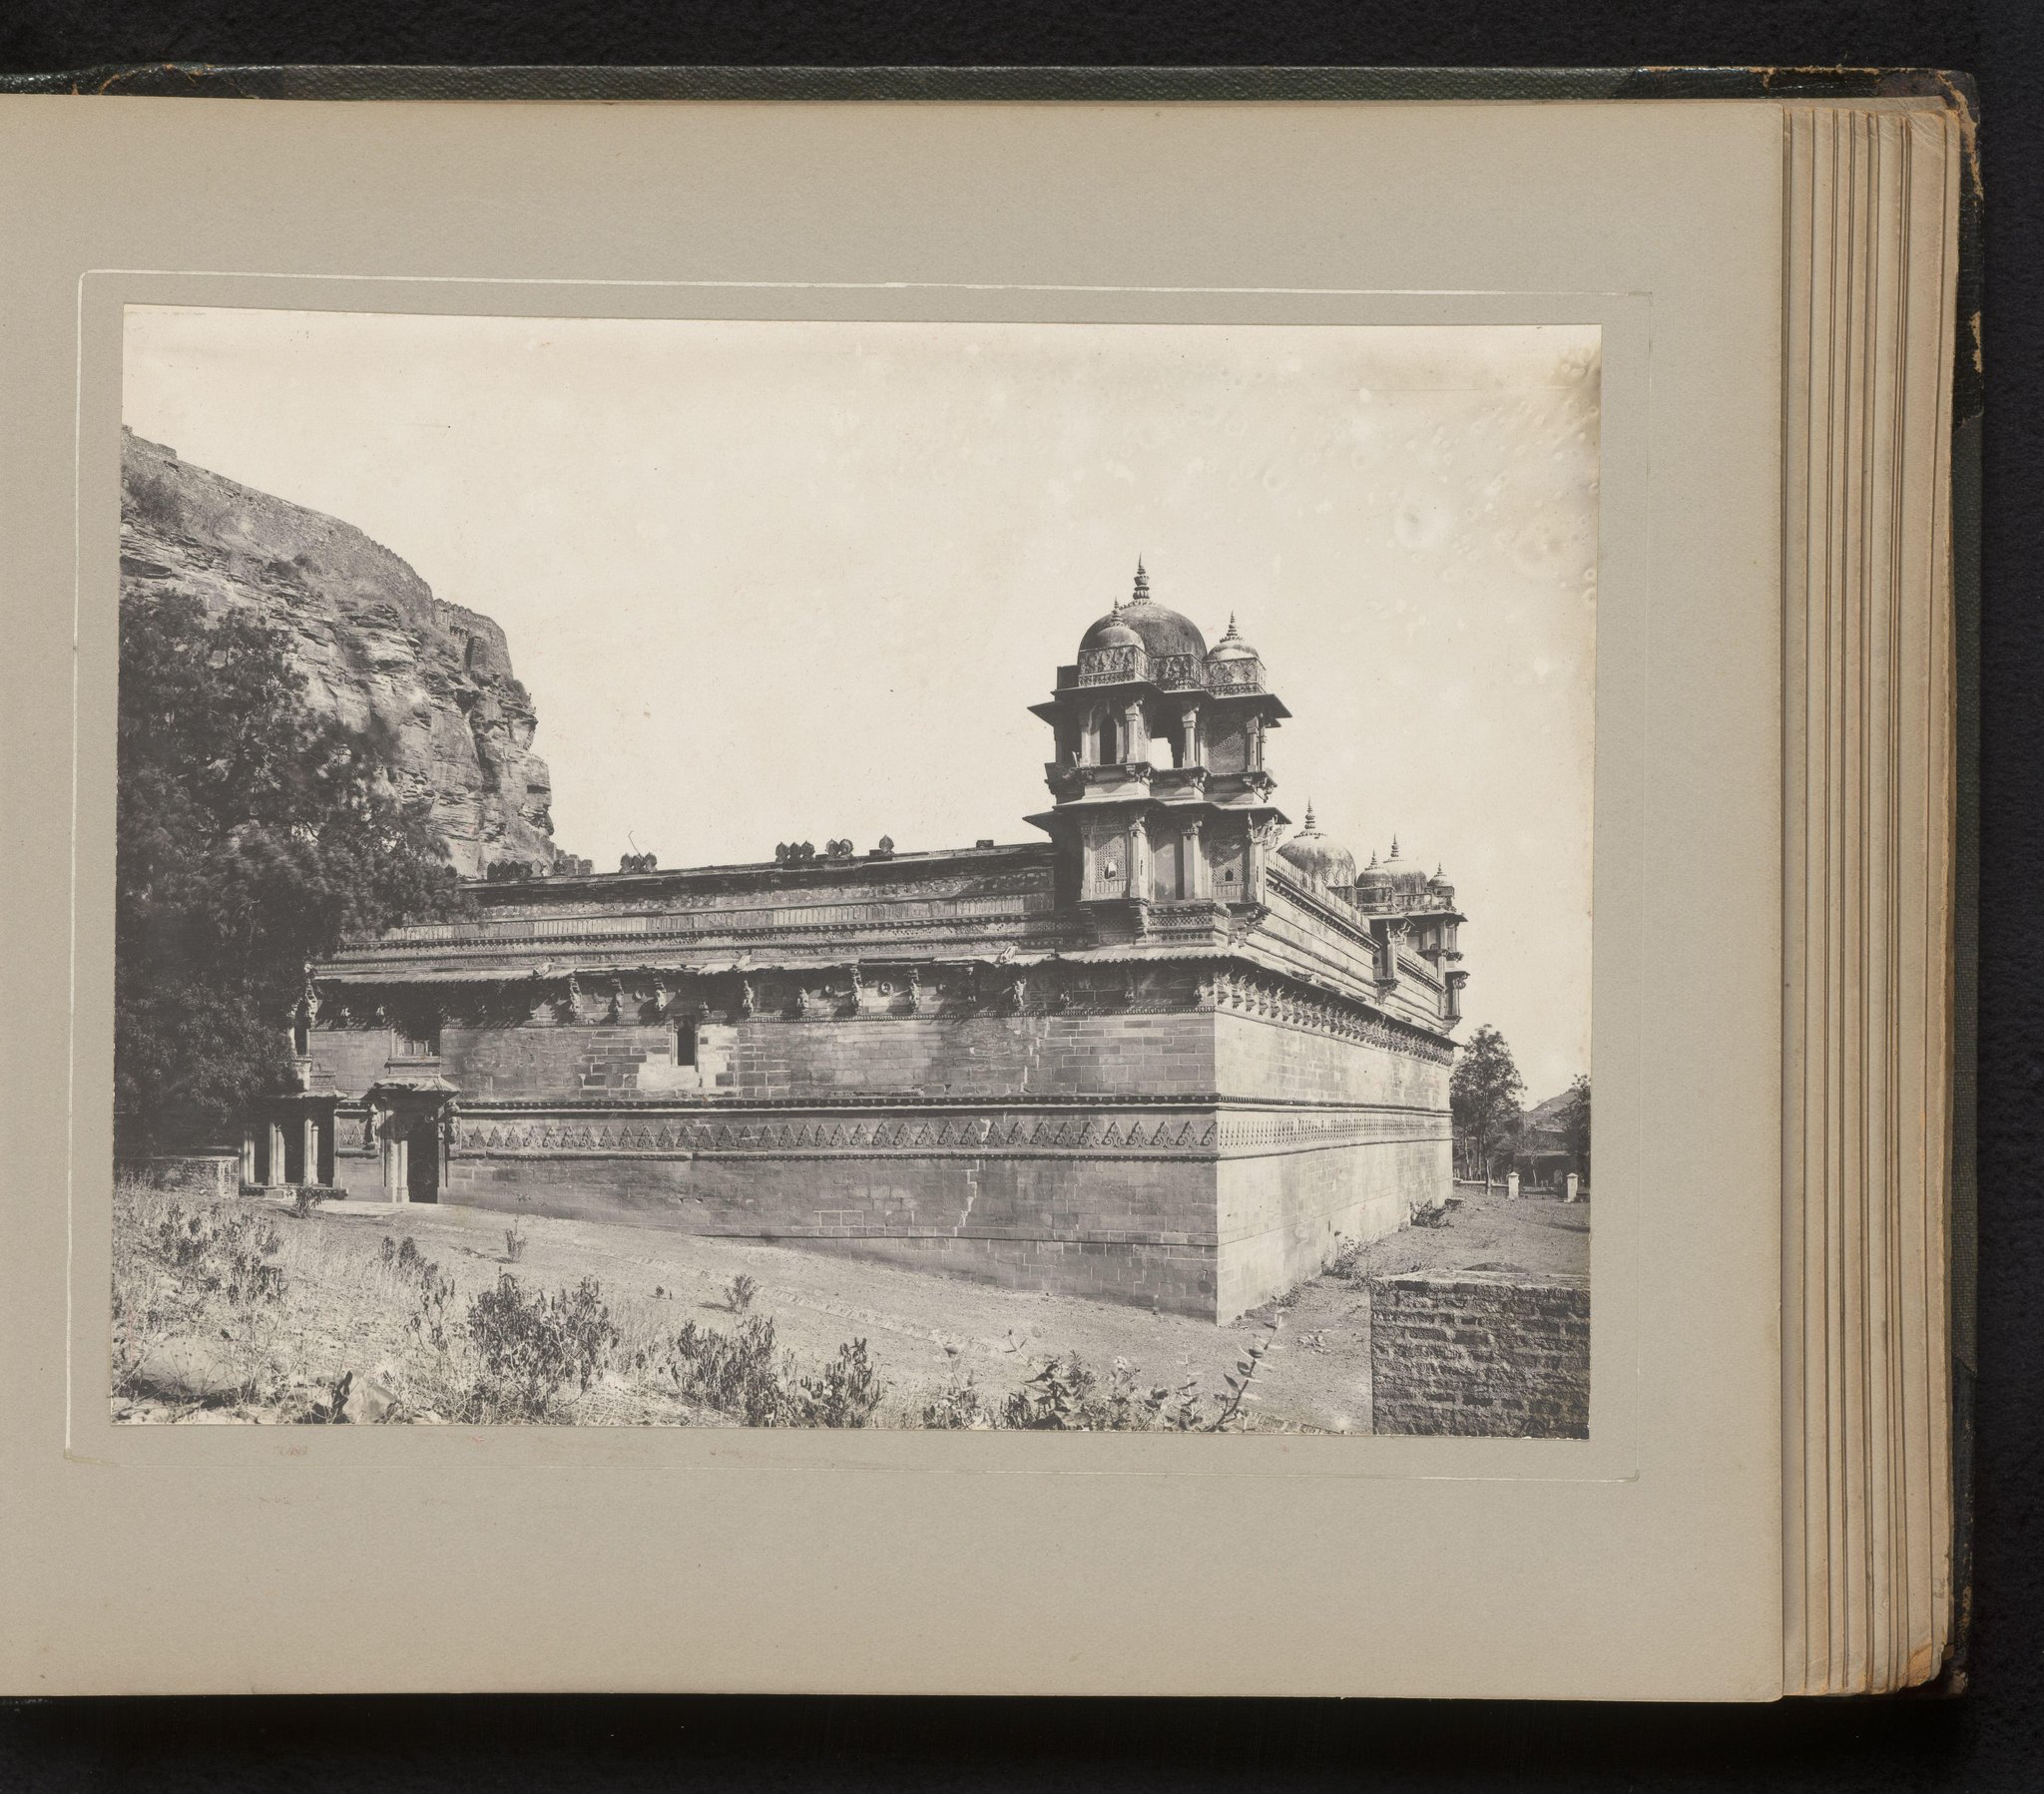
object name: page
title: Gujari Mahal paleis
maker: k.h. mawal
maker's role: fotograaf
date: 1900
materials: photographic support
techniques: gelatin silver print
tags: civic architecture; edifices; dwellings